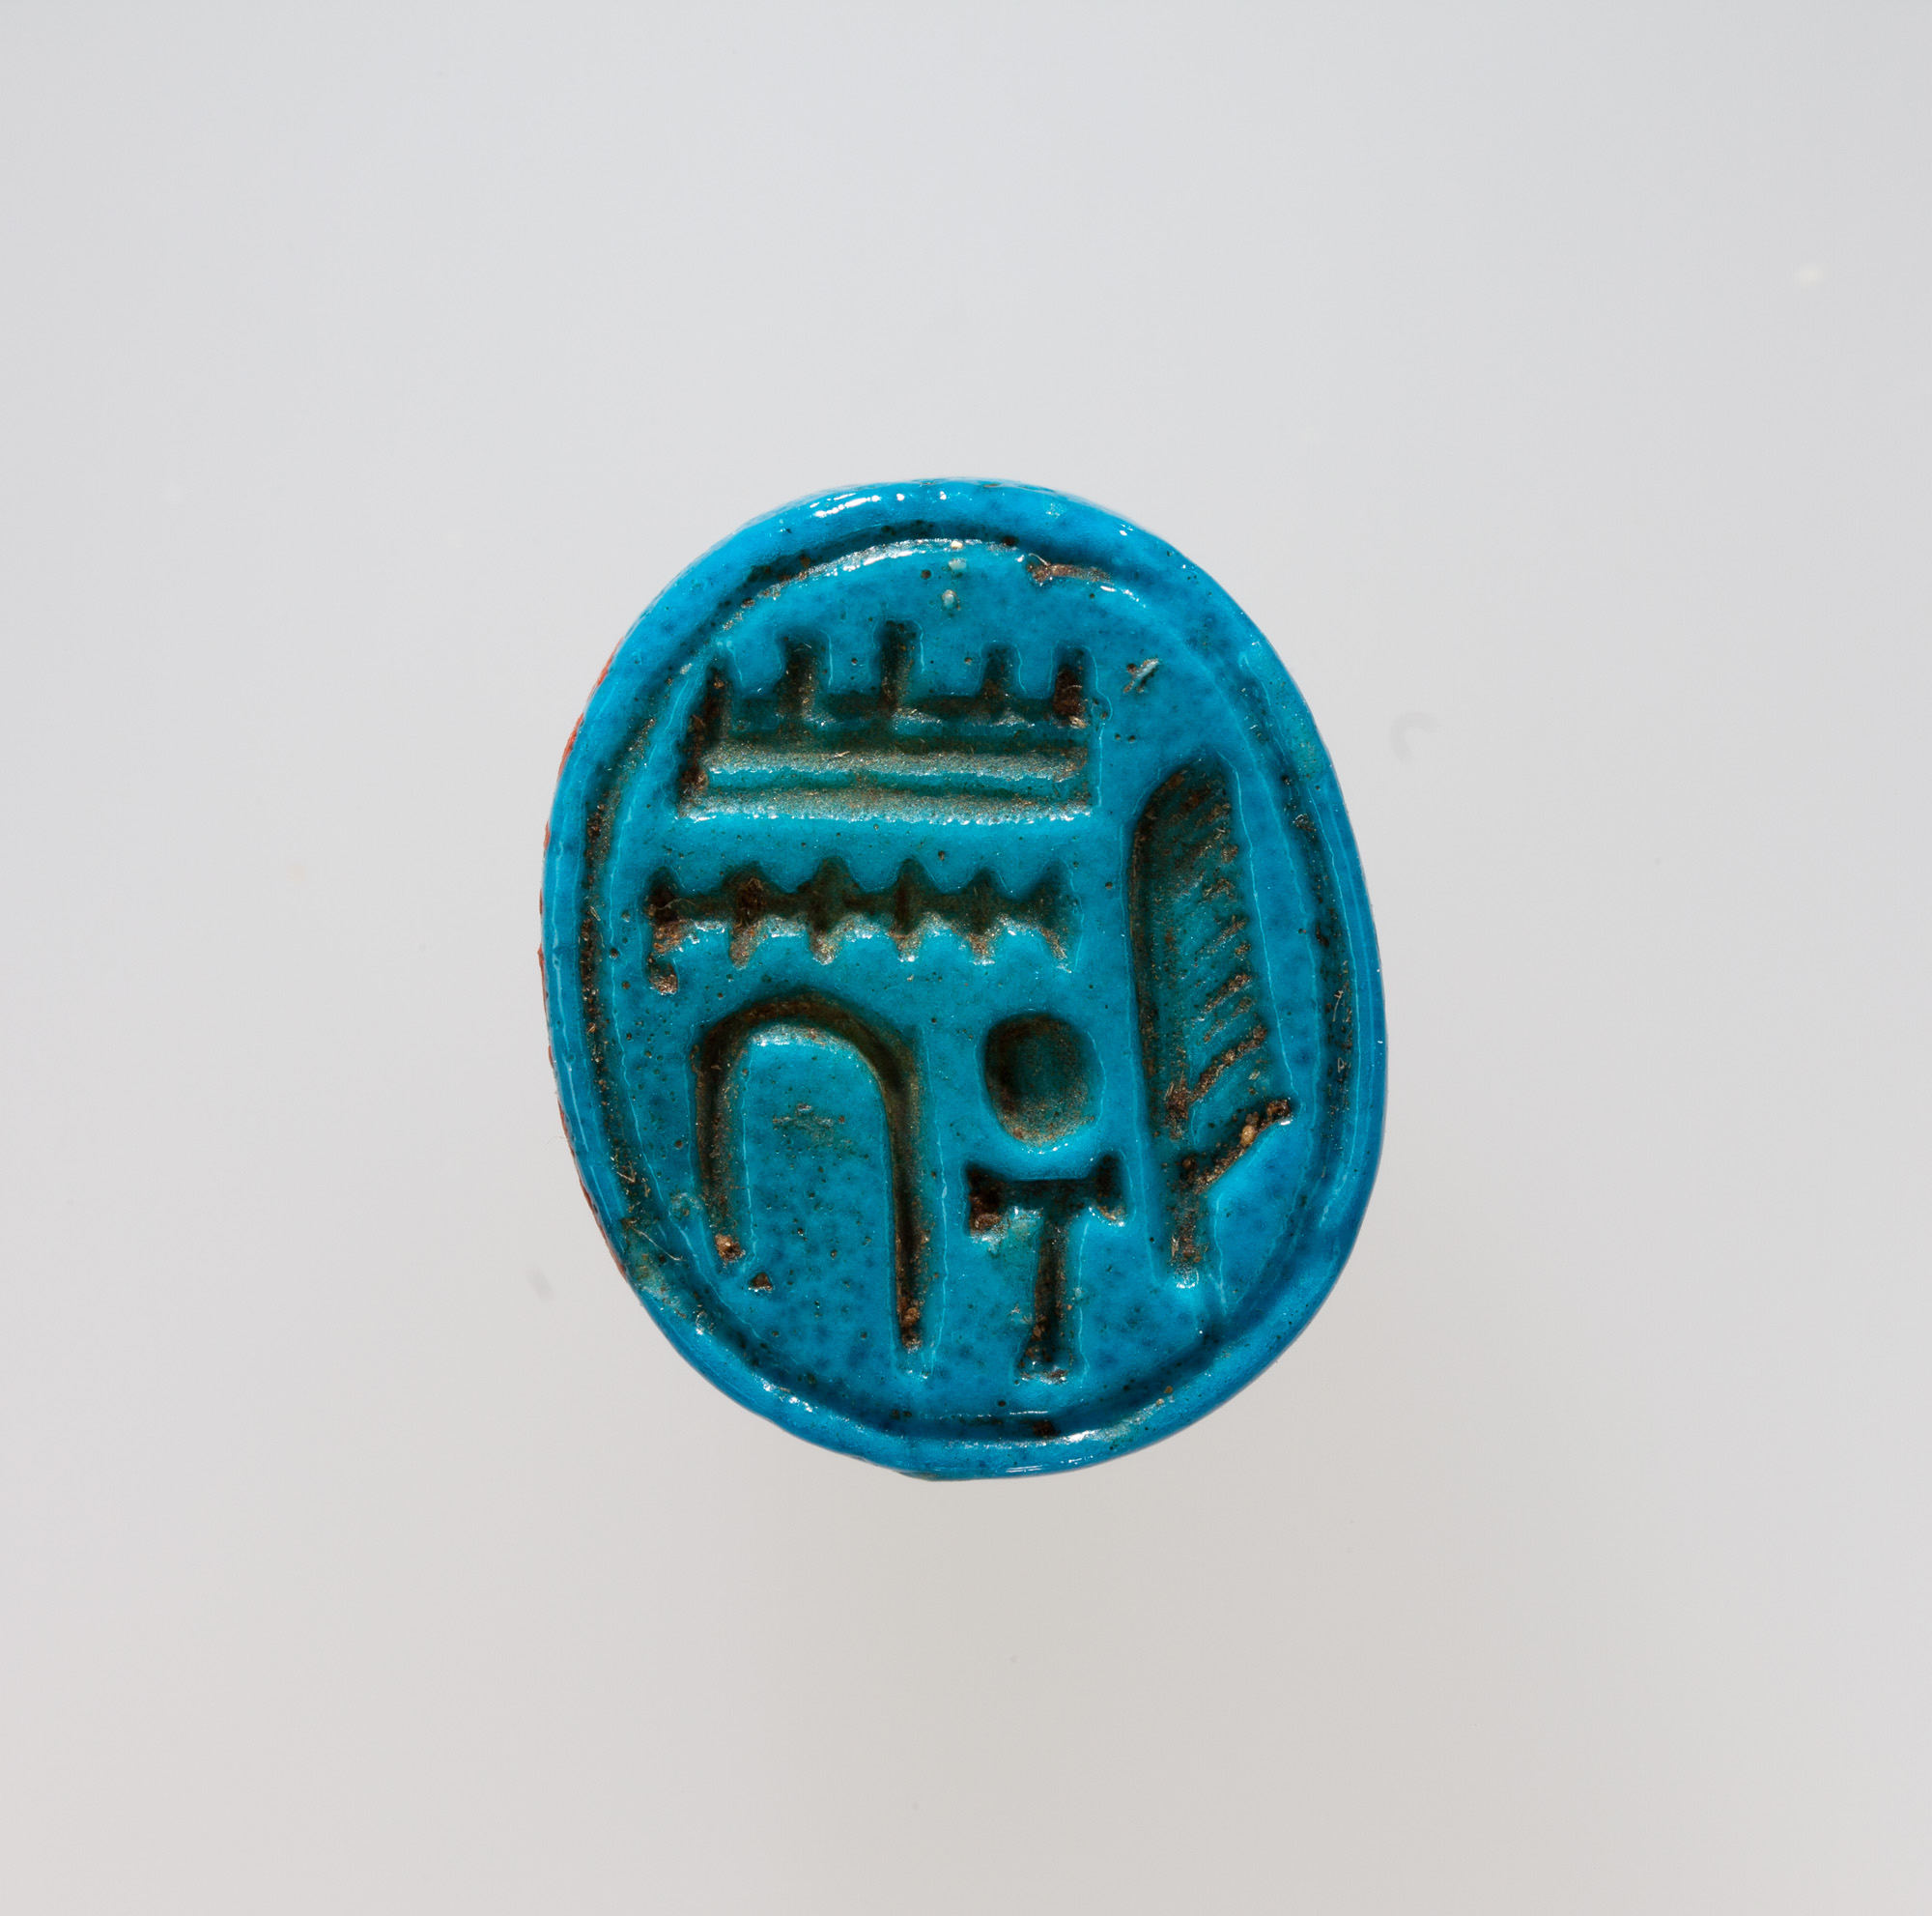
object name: scarab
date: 1479-1458 BCE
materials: faience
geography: egypt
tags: scarabs